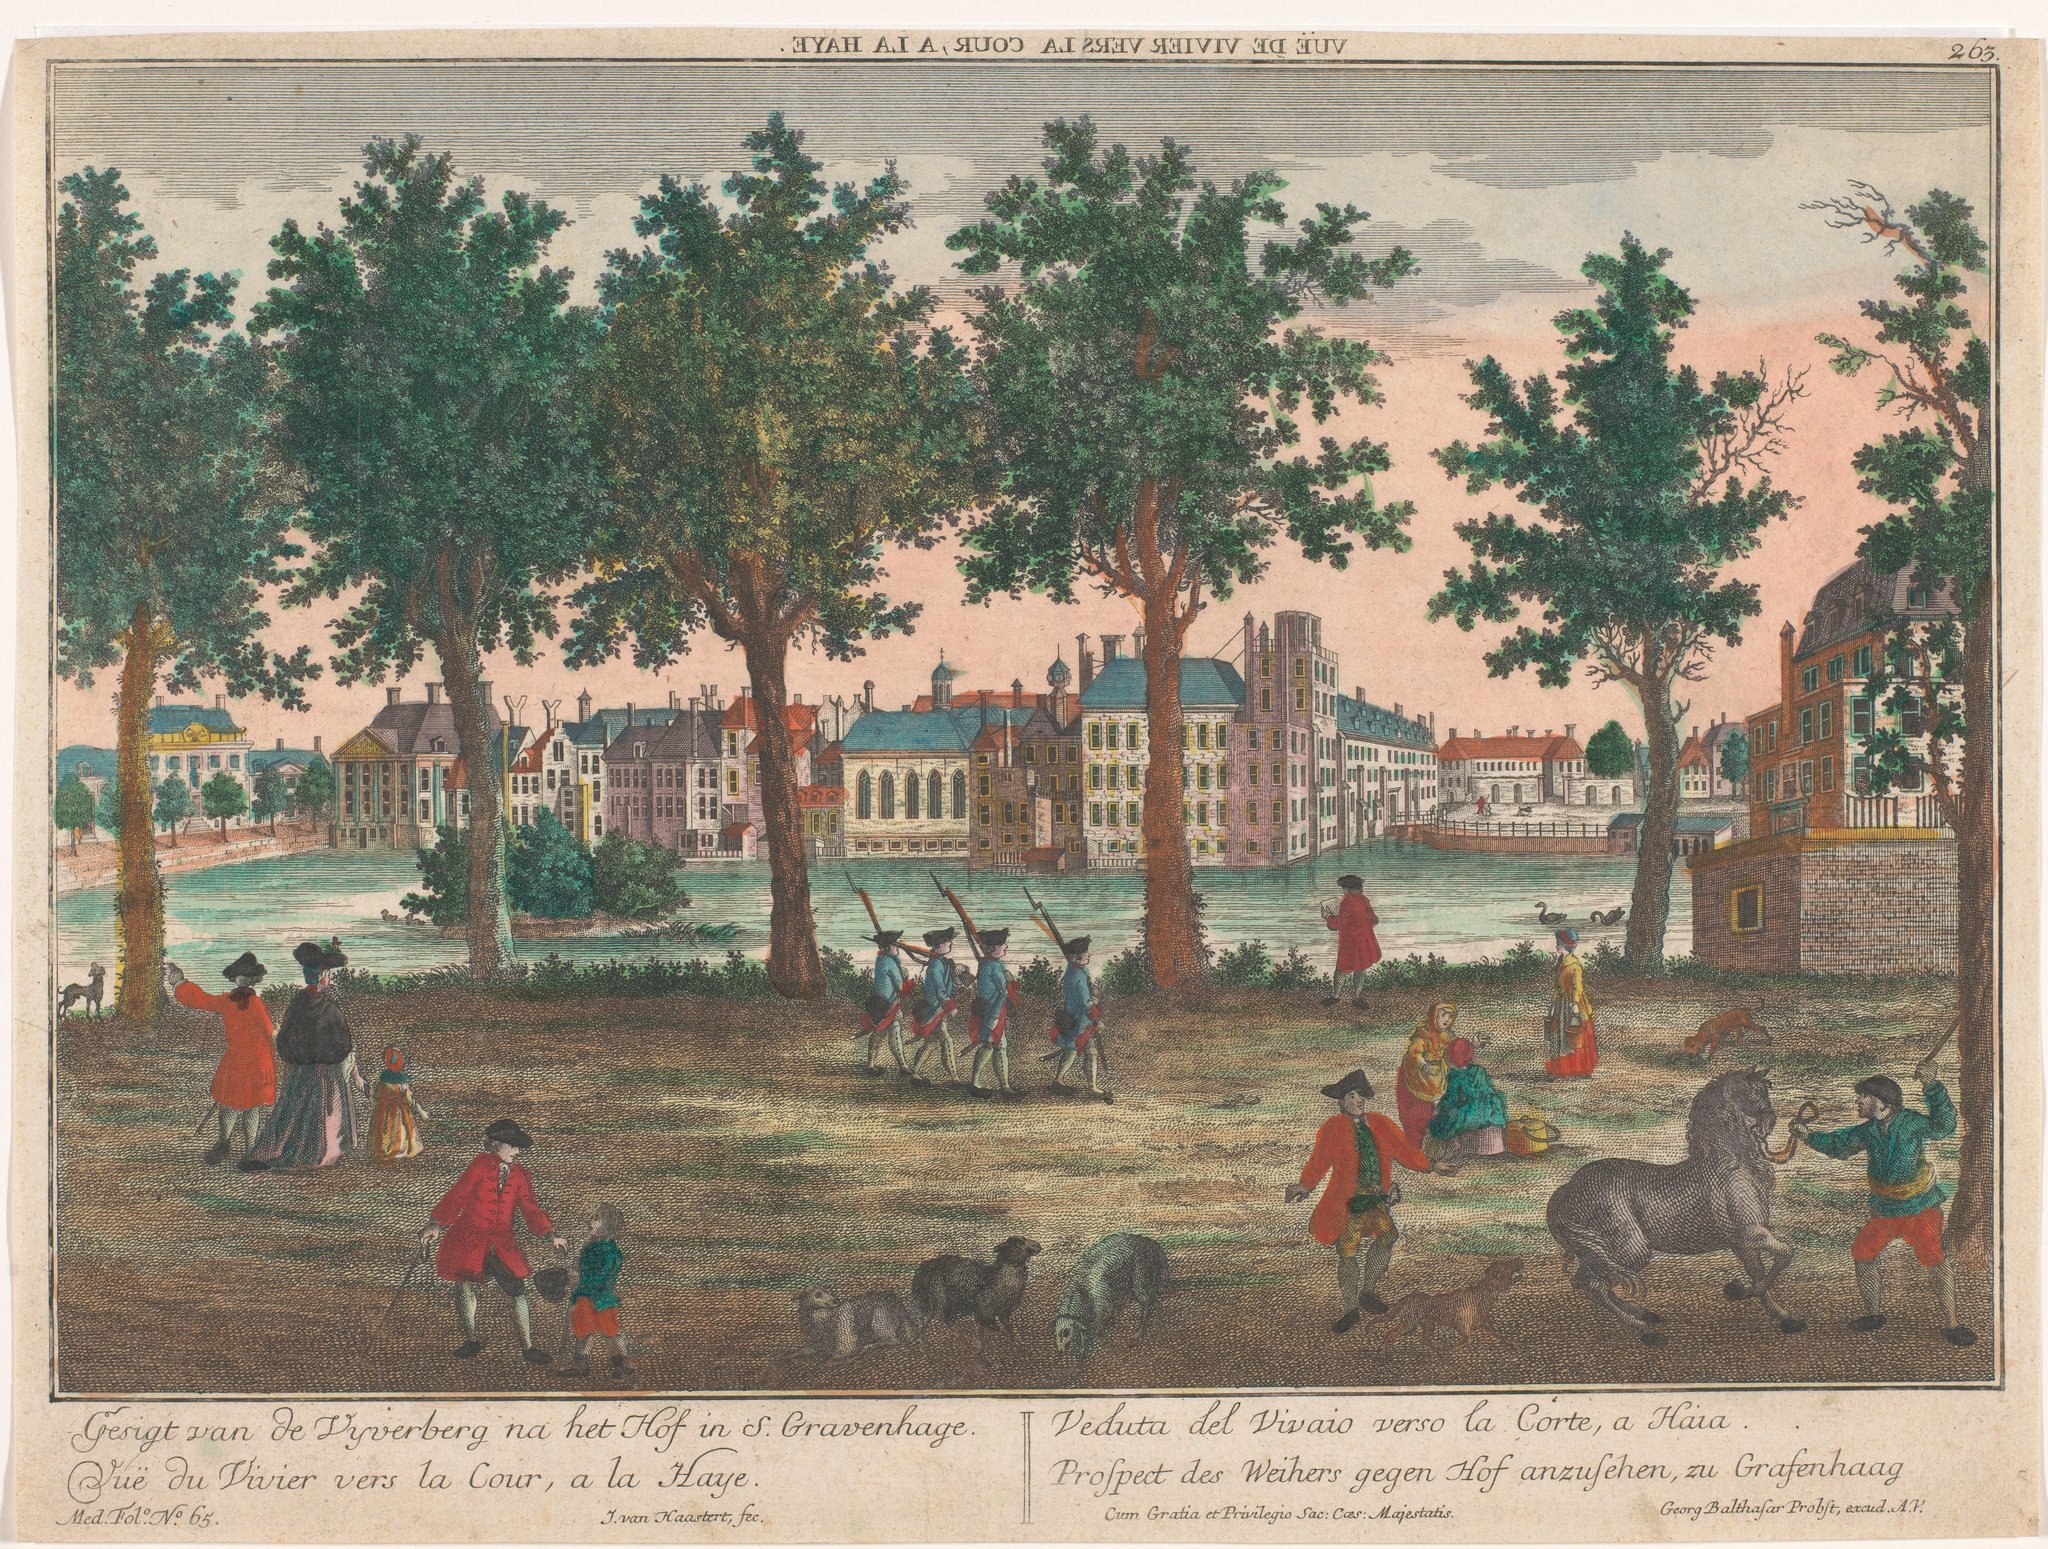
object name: print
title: Prospect des Weihers gegen Hof anzusehen, zu Grafenhaag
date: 1742-1801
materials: paper, watercolor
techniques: brush, etching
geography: germany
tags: parts of church exterior and annexes: chapel, canals, waters (in city) (+ city(-scape) with figures, staffage), street (+ city(-scape) with figures, staffage)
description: Op de voorgrond de Vijverberg. Links het Mauritshuis en het Binnenhof met de Hofkapel. Rechts het Buitenhof. Rechtsboven genummerd: 263. Linksonder genummerd: 65.